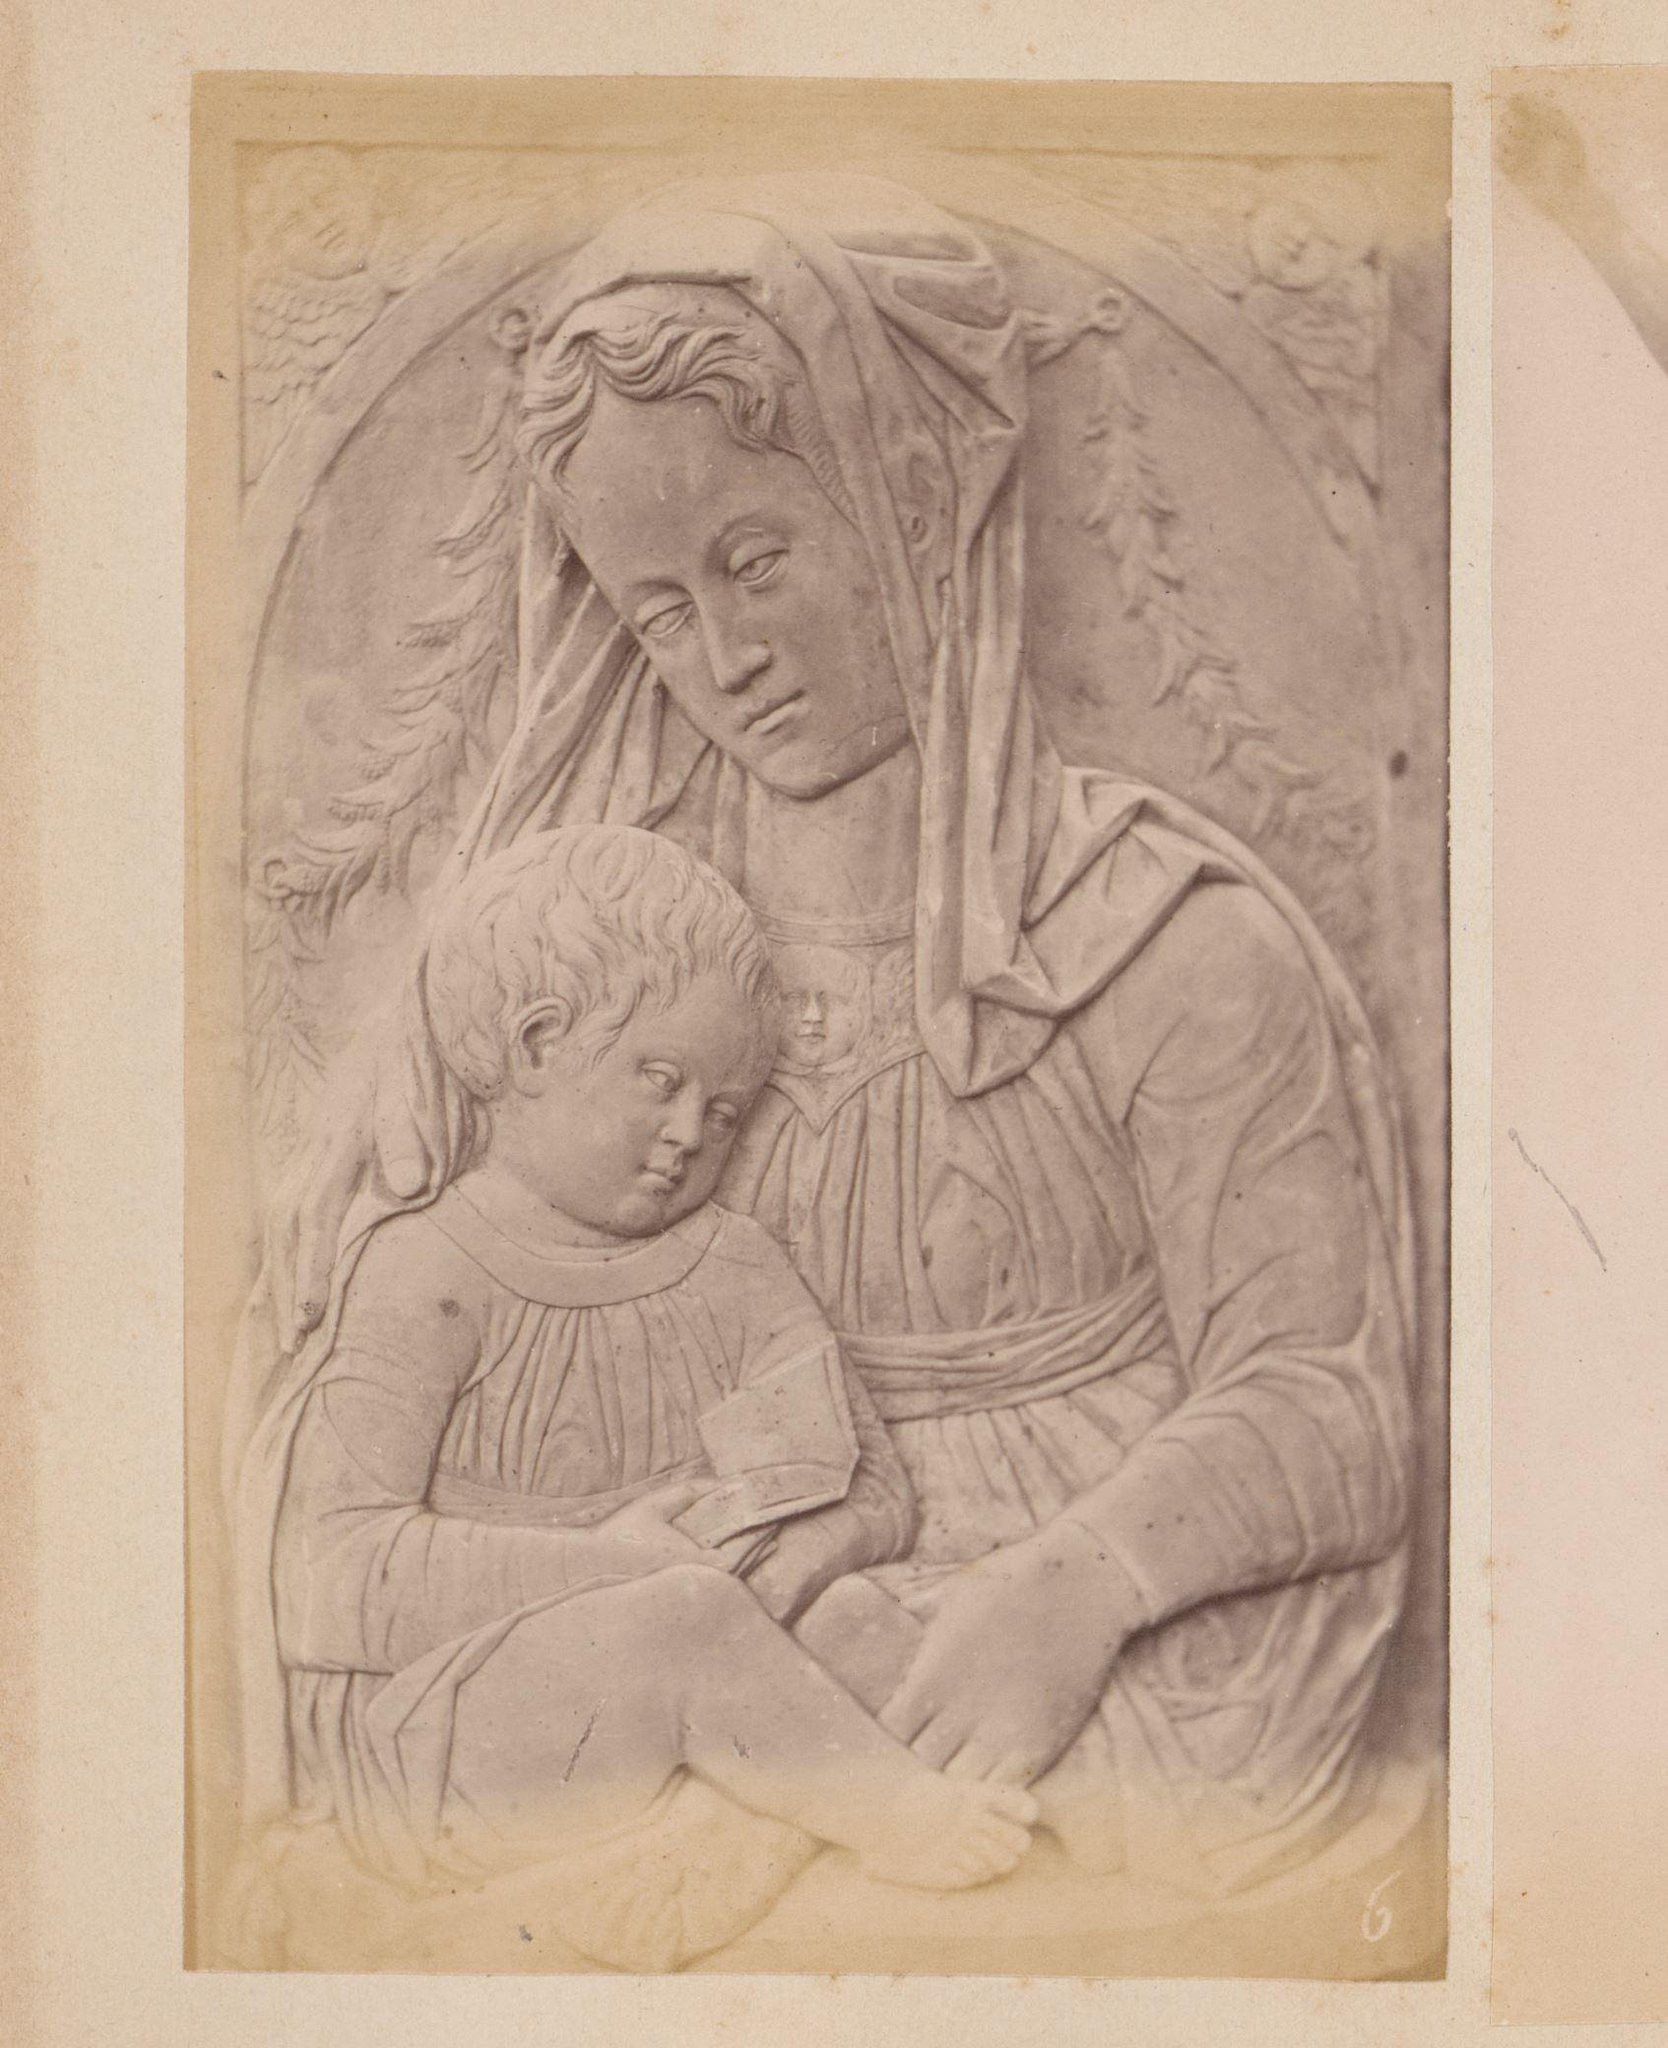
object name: page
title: Kerkobject, Maria met kind reliëf van Donatello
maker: Anonymous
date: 1860-1885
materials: photographic support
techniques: albumen print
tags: madonna: i.e. mary with the christ-child